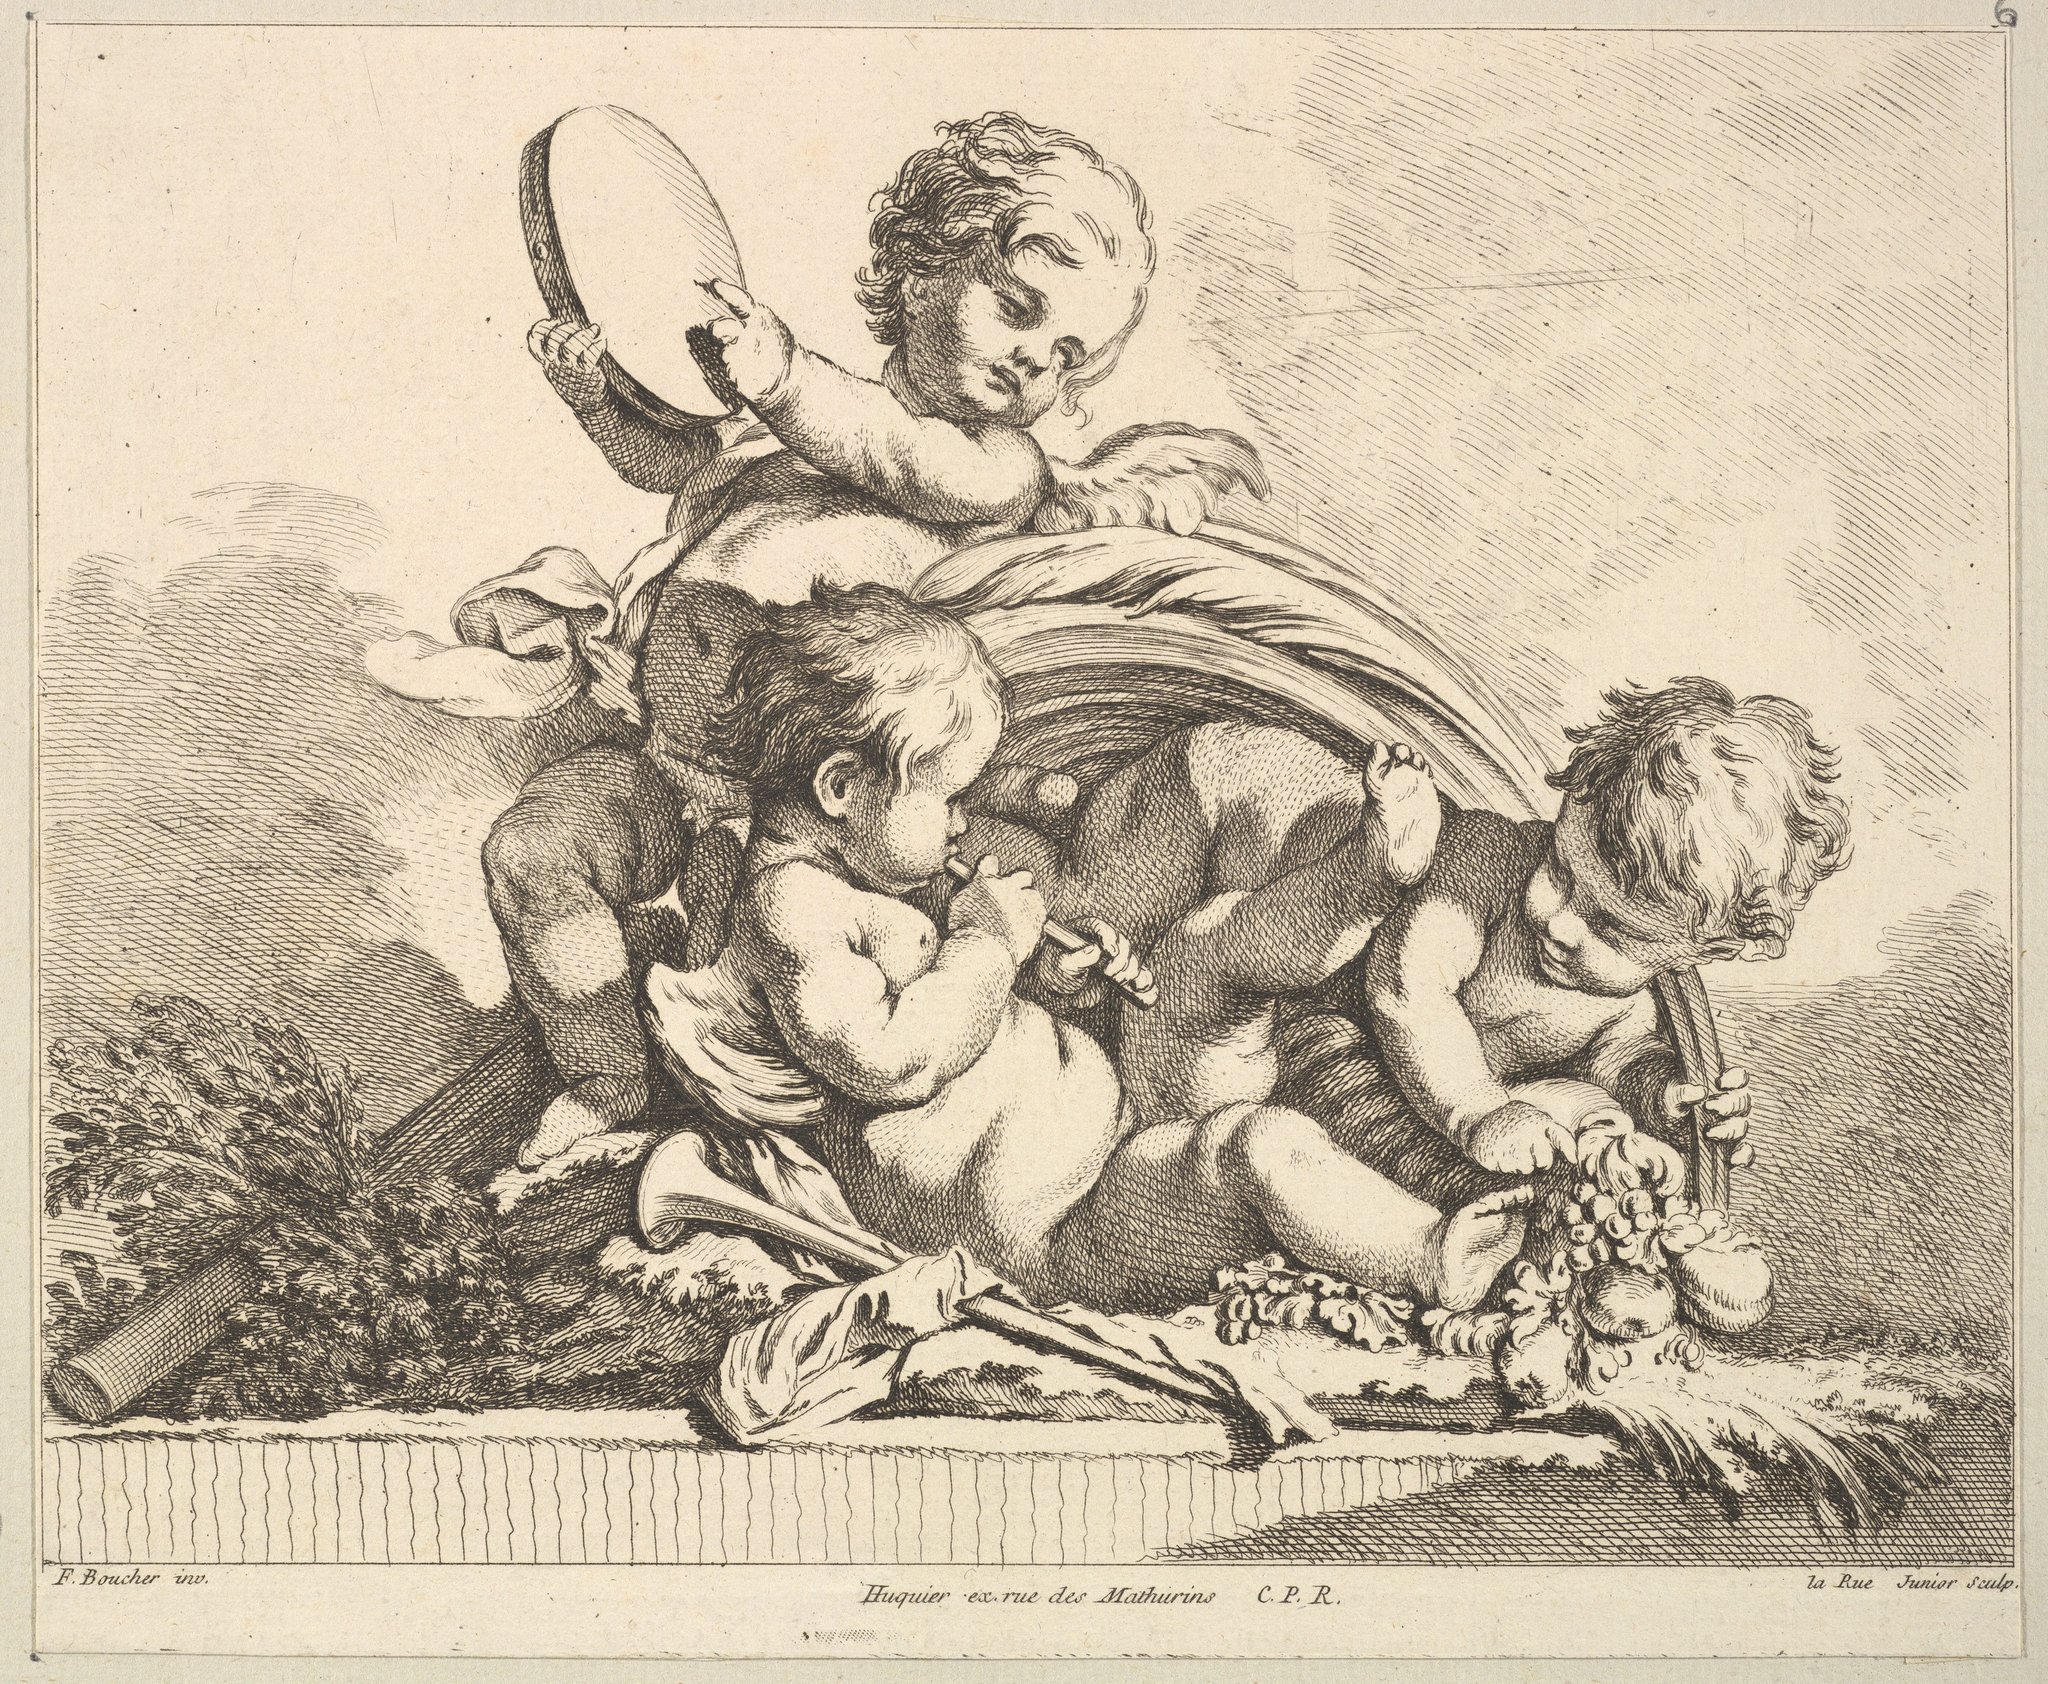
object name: print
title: Three Cupids, Two Playing Music, One Holding Palm Leaves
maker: louis félix de la rue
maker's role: artist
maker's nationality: french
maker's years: 1731-1765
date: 1731-1765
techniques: engraving, etching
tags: musical instruments,cupid,leaves,palms